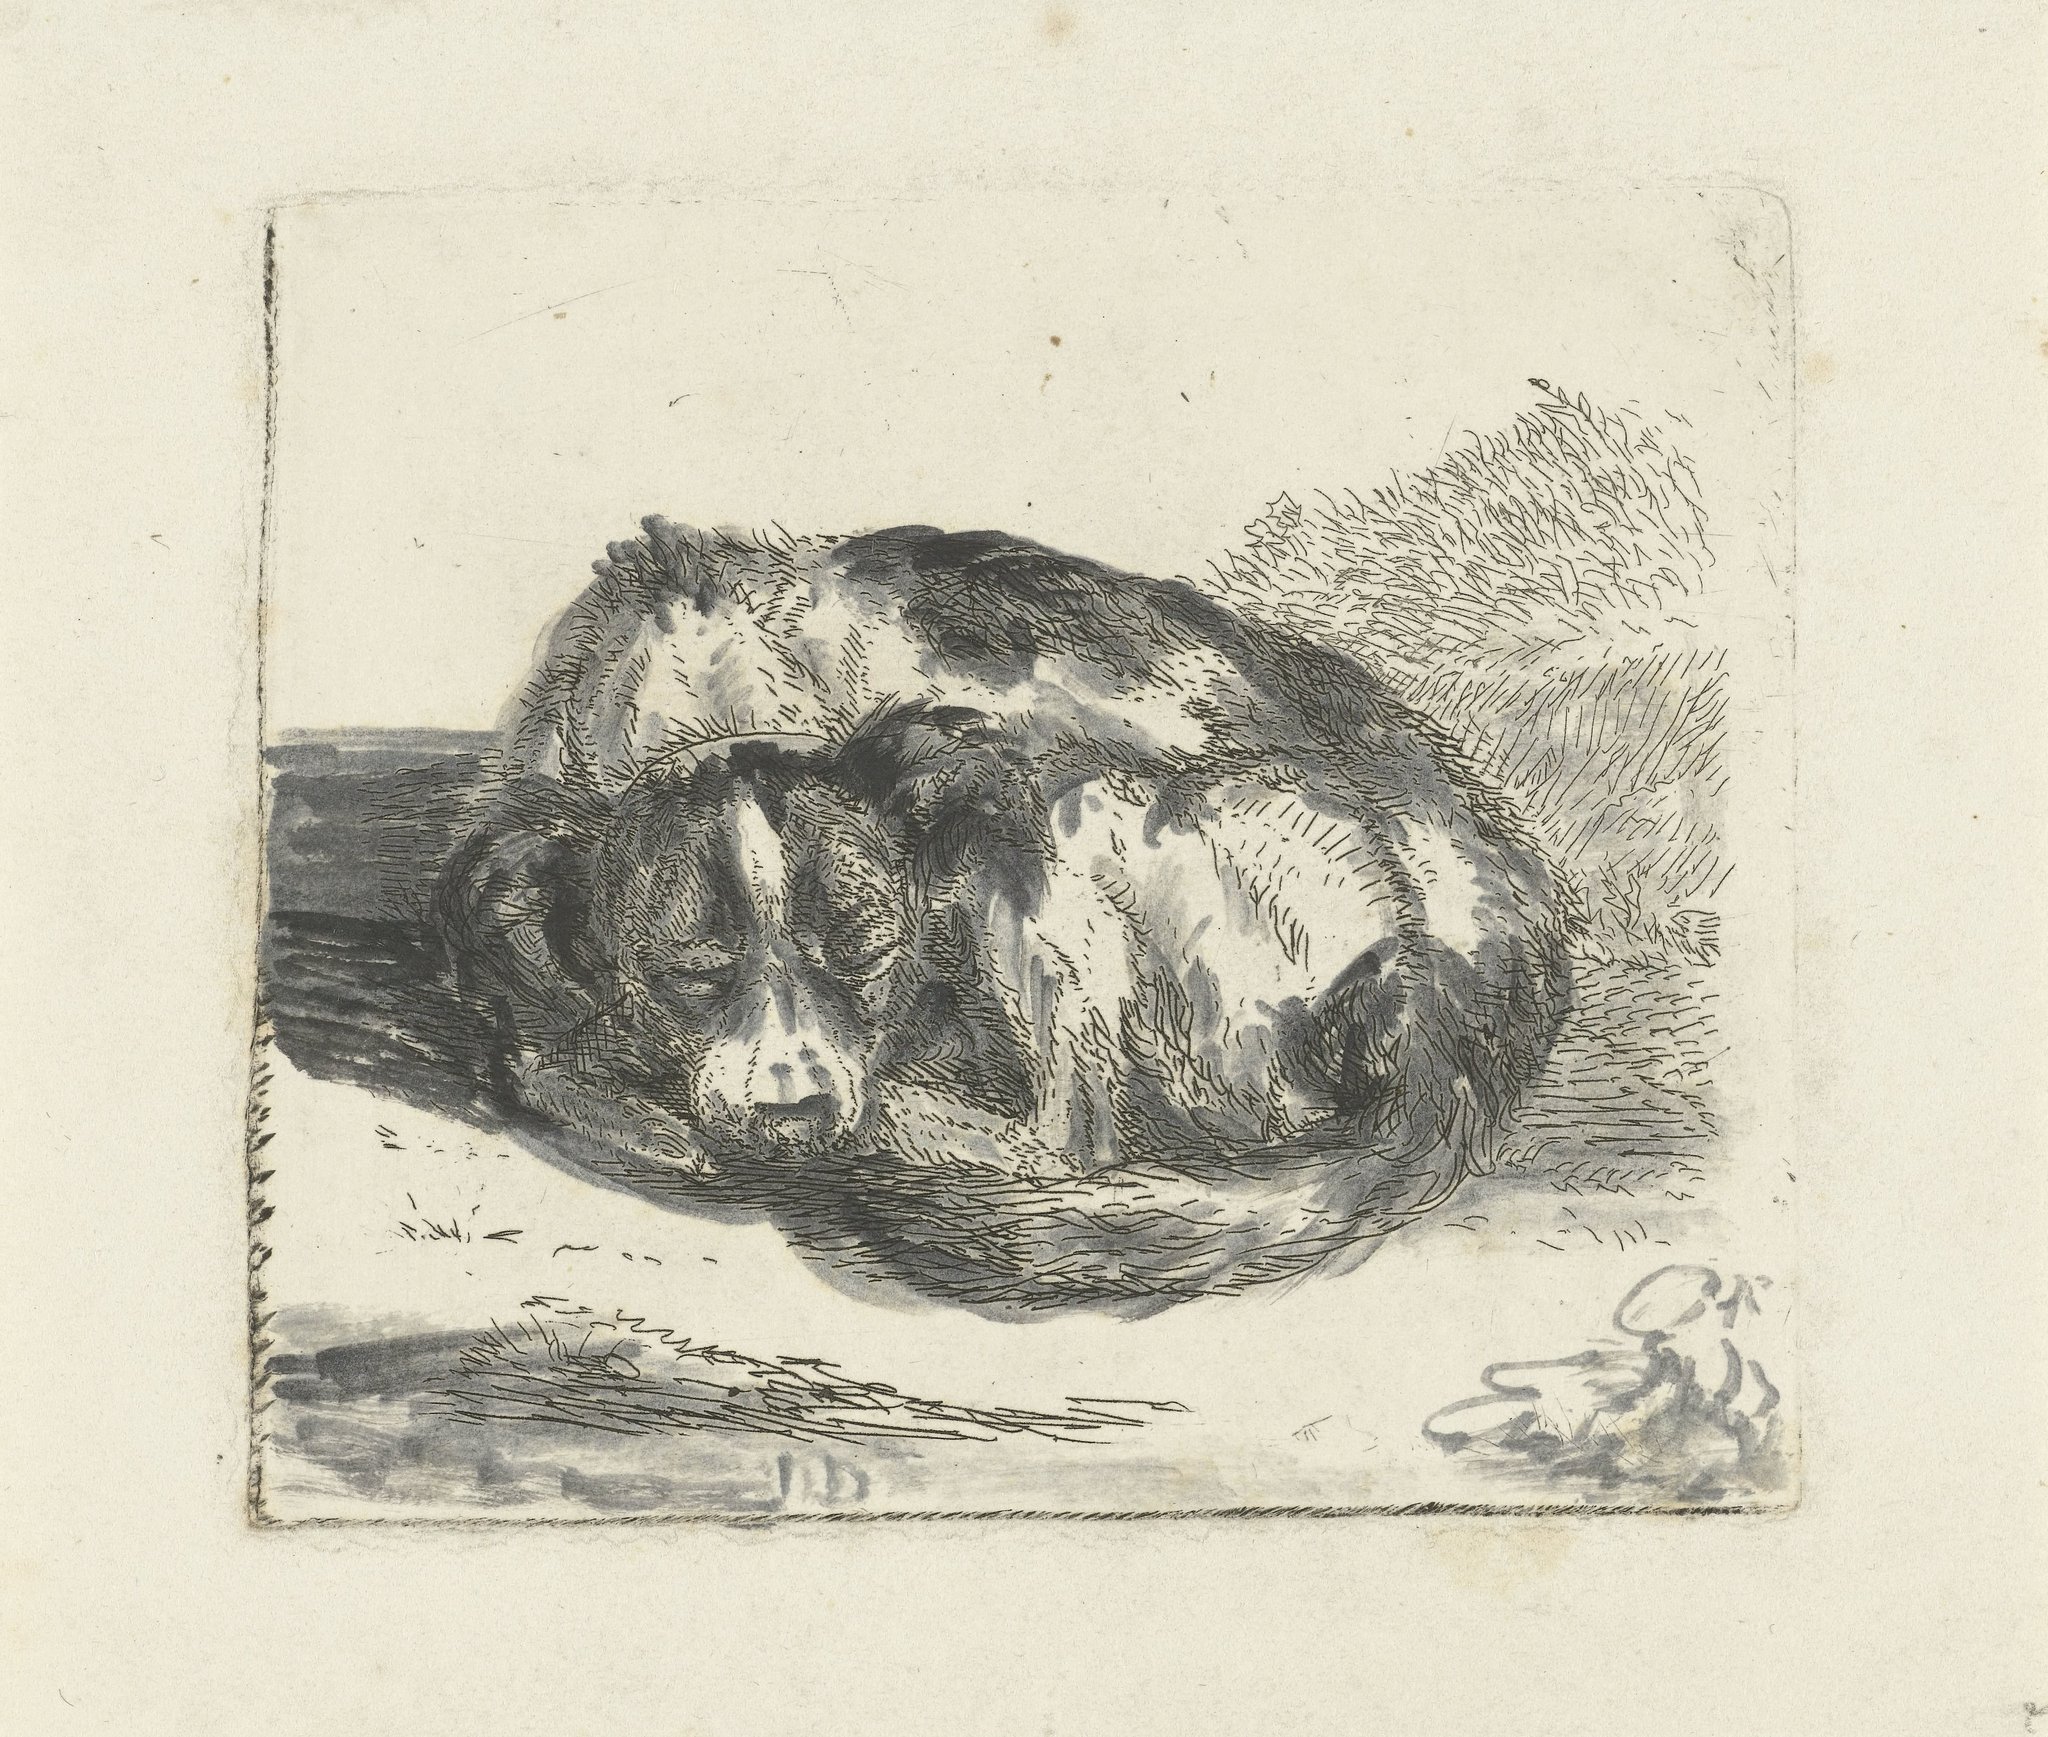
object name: print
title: Slapende hond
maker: jan dasveldt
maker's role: draughtsman, print maker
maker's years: 1770-1855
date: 1780-1855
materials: paper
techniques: brush, etching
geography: amsterdam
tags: dog (+ sleeping animal(s))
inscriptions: collector's mark: Lugt 2228